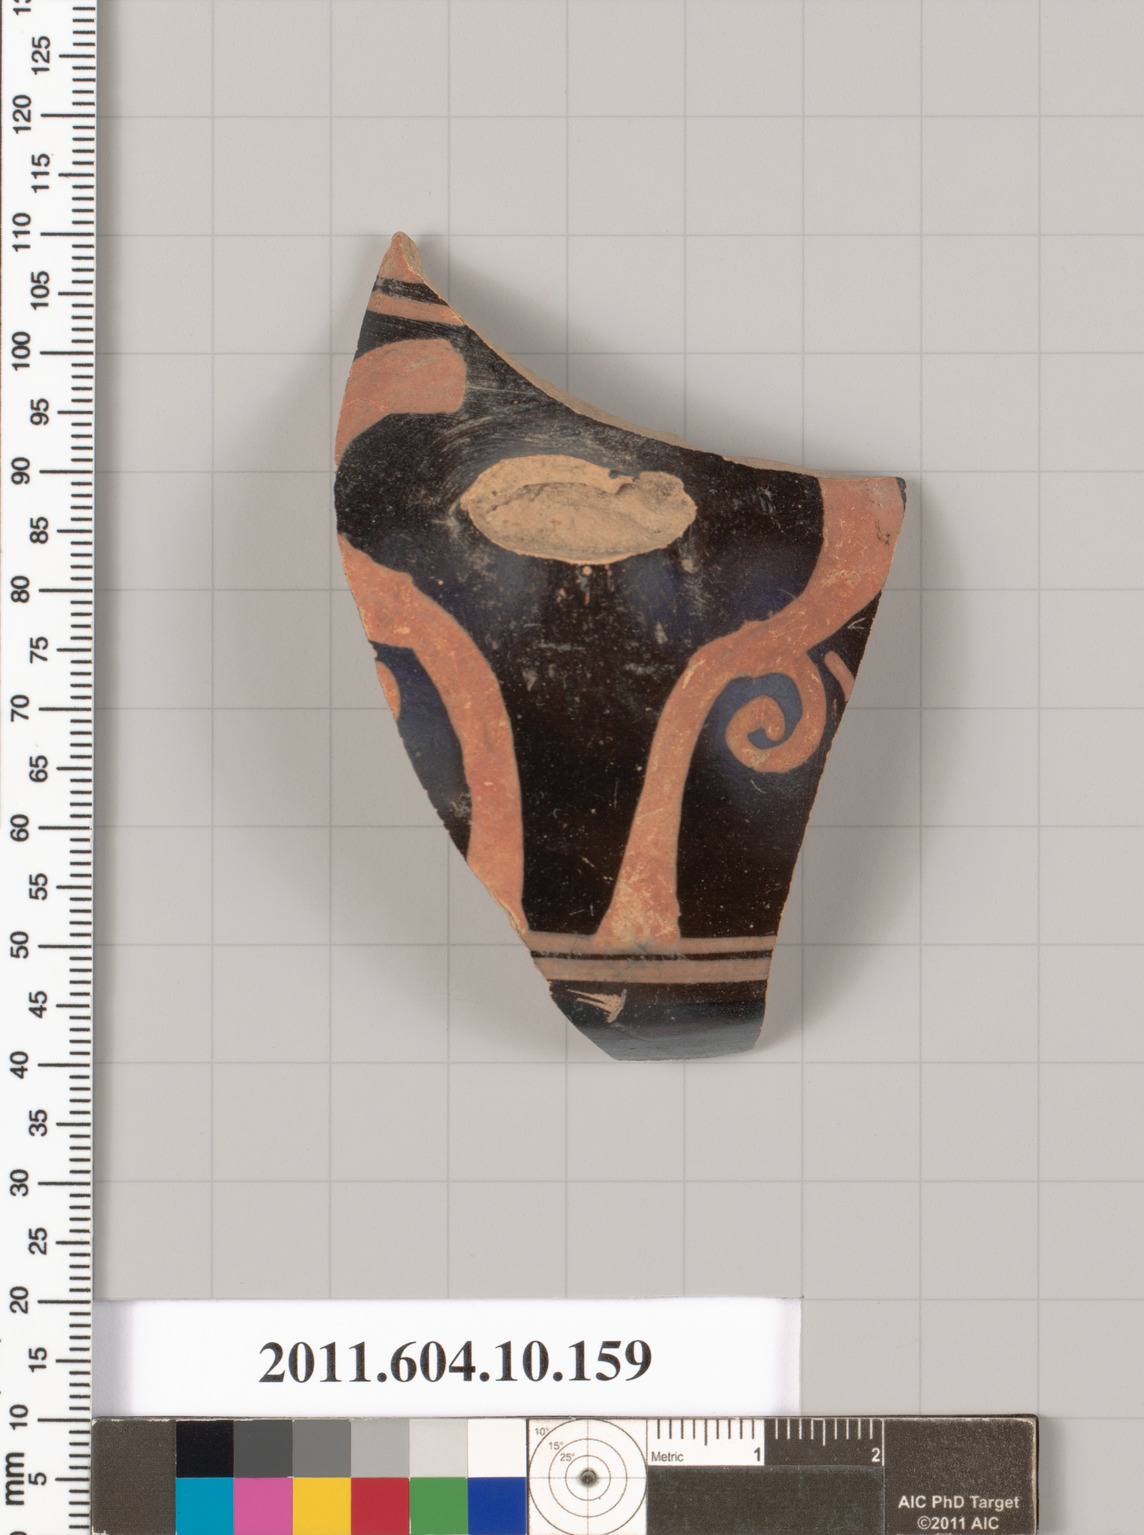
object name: skyphos fragment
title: Terracotta fragment of a skyphos (deep drinking cup)?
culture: etruscan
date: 434-368 BCE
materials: terracotta